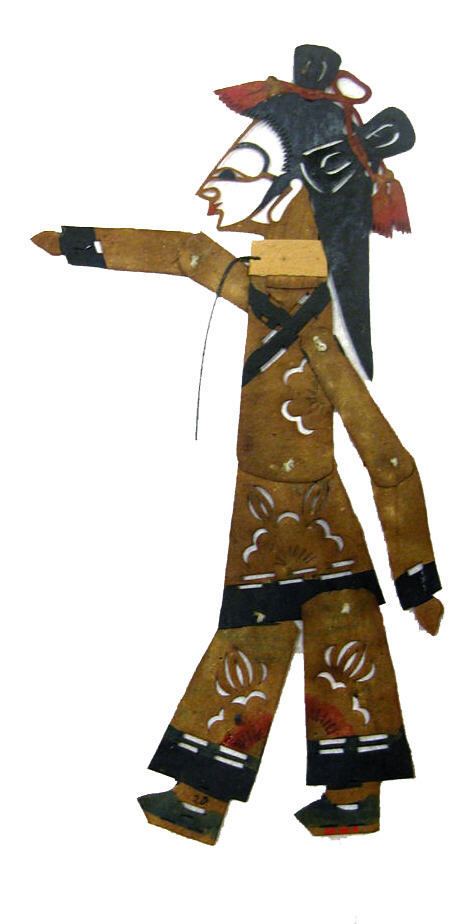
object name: shadow player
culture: chinese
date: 1801-1900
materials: cord, skin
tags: human figures